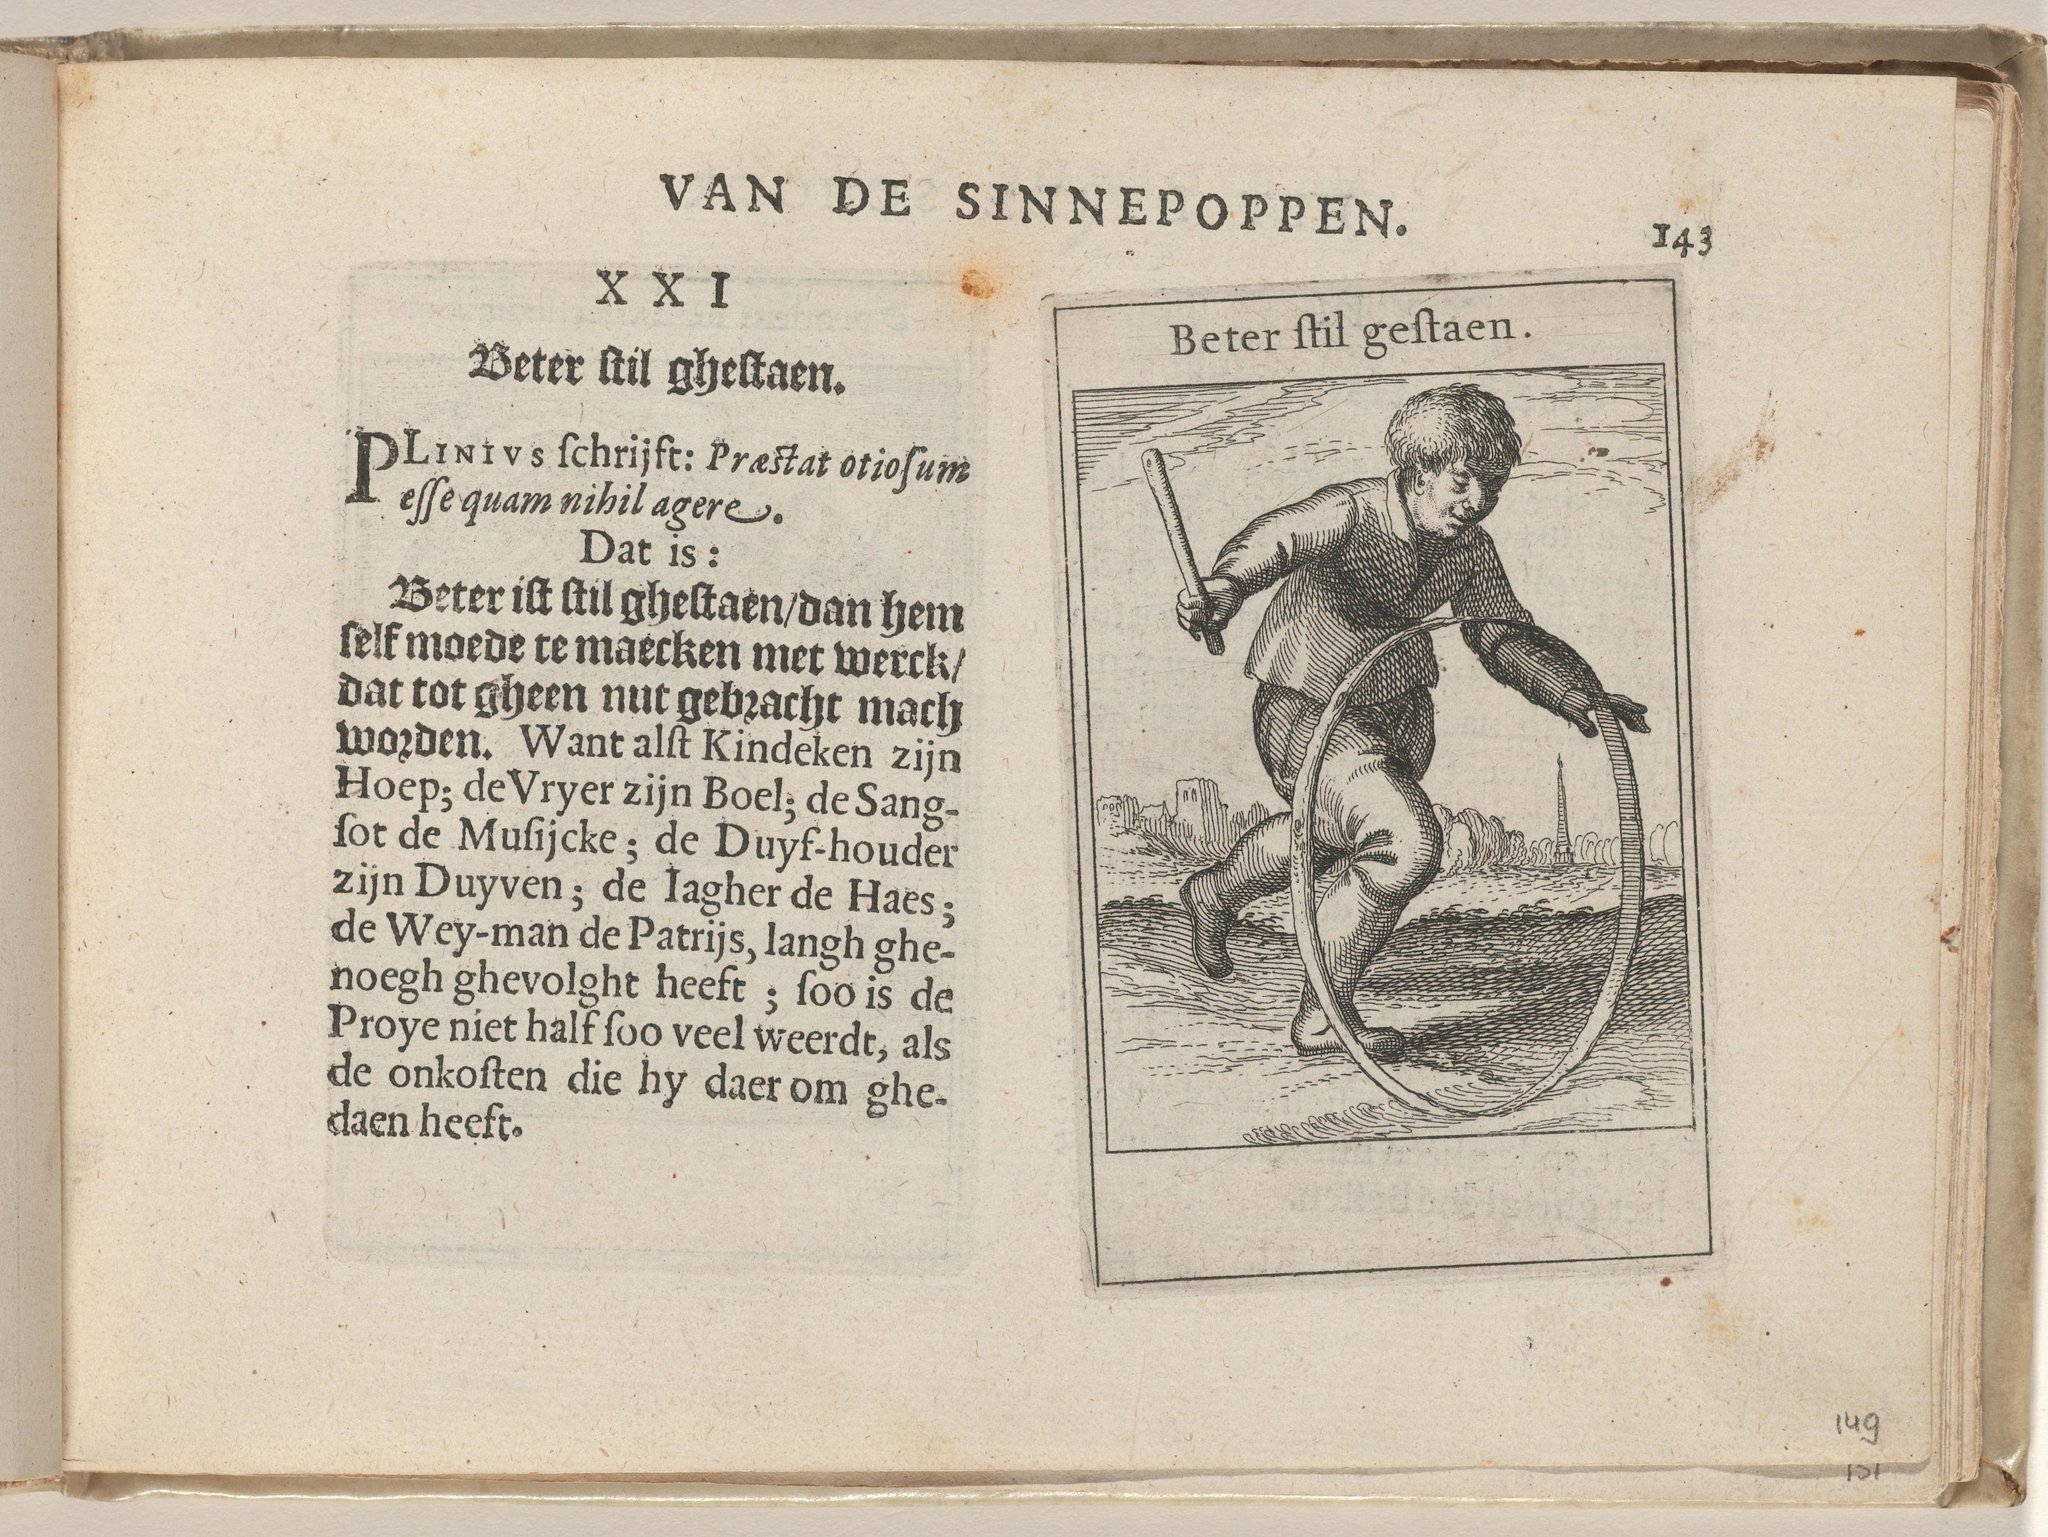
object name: album leaf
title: XXI Beter stil gestaen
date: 1614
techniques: engraving, printing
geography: the hague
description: XXI Beter stil gestaen. Derde schok. Onderdeel van 'Sinnepoppen', R. Visscher, 1614.